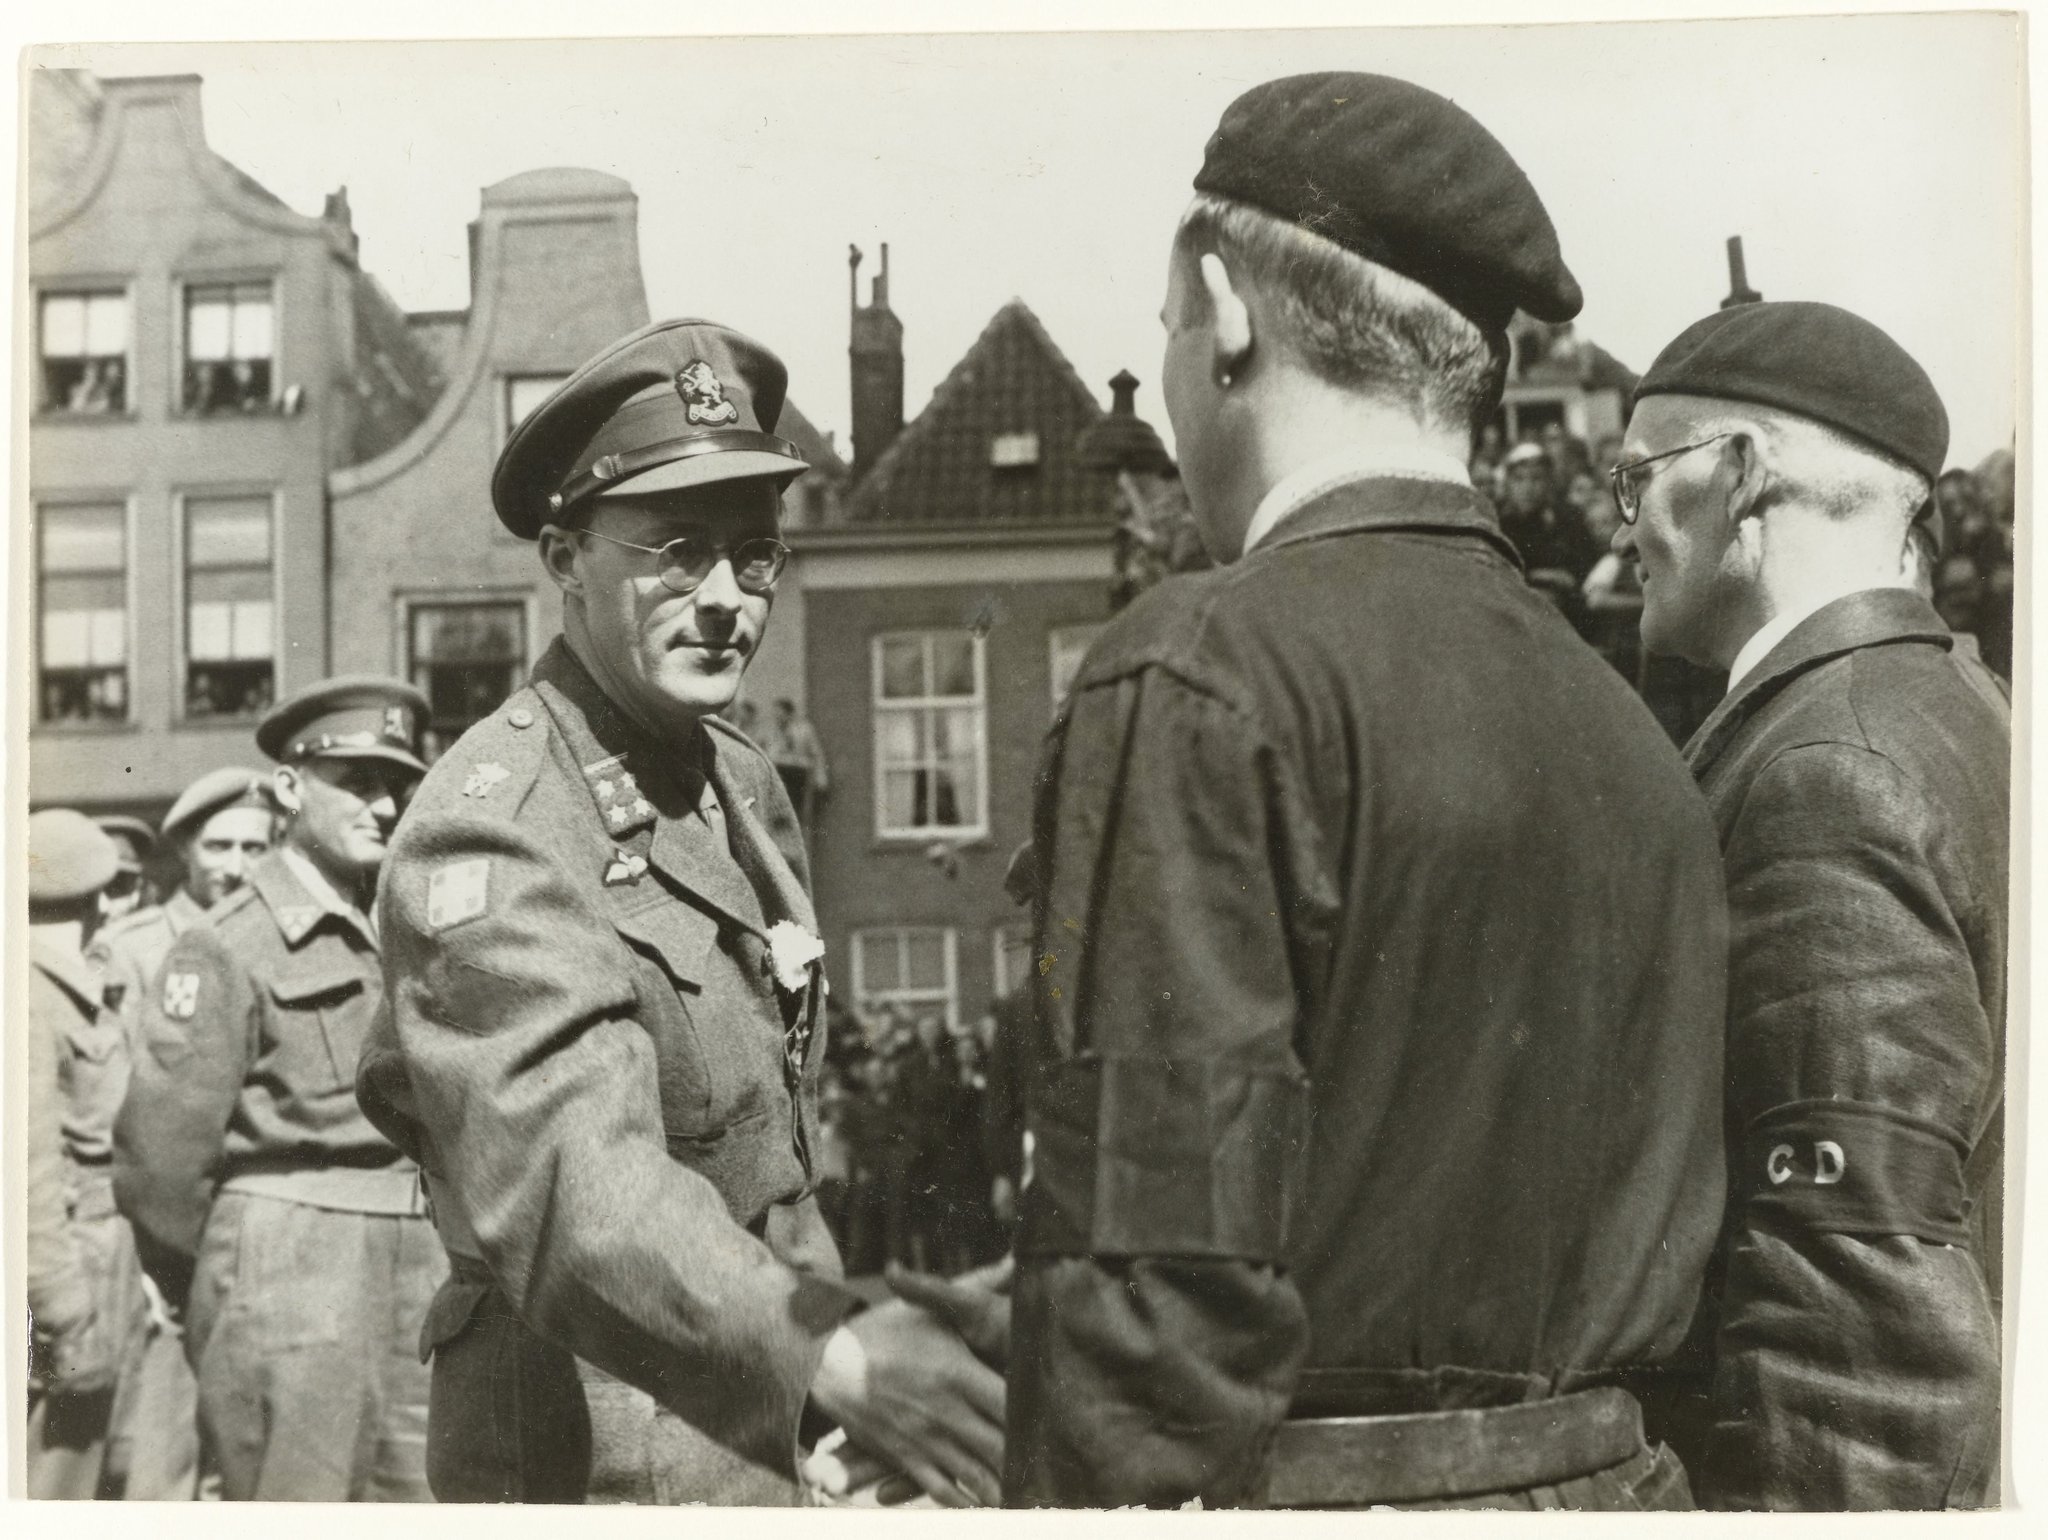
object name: photograph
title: Prins Bernhard met militairen van Binnenlandse Strijdkrachten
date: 1906-1945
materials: photographic support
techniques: photography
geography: delft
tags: utrecht, bernhard (prins der nederlanden), delft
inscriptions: stamp: ‘COPYRIGHT / 'ANEFO' / ALGEMEEN NEDERLANDSCH FOTOBUREAU’, inscription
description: Prins Bernhard maakte ter ere van zijn verjaardag, 29 juni 1945, een tocht langs Nederlandse steden met militairen van Binnenlandse Strijdkrachten. Iedereen droeg een witte anjer.